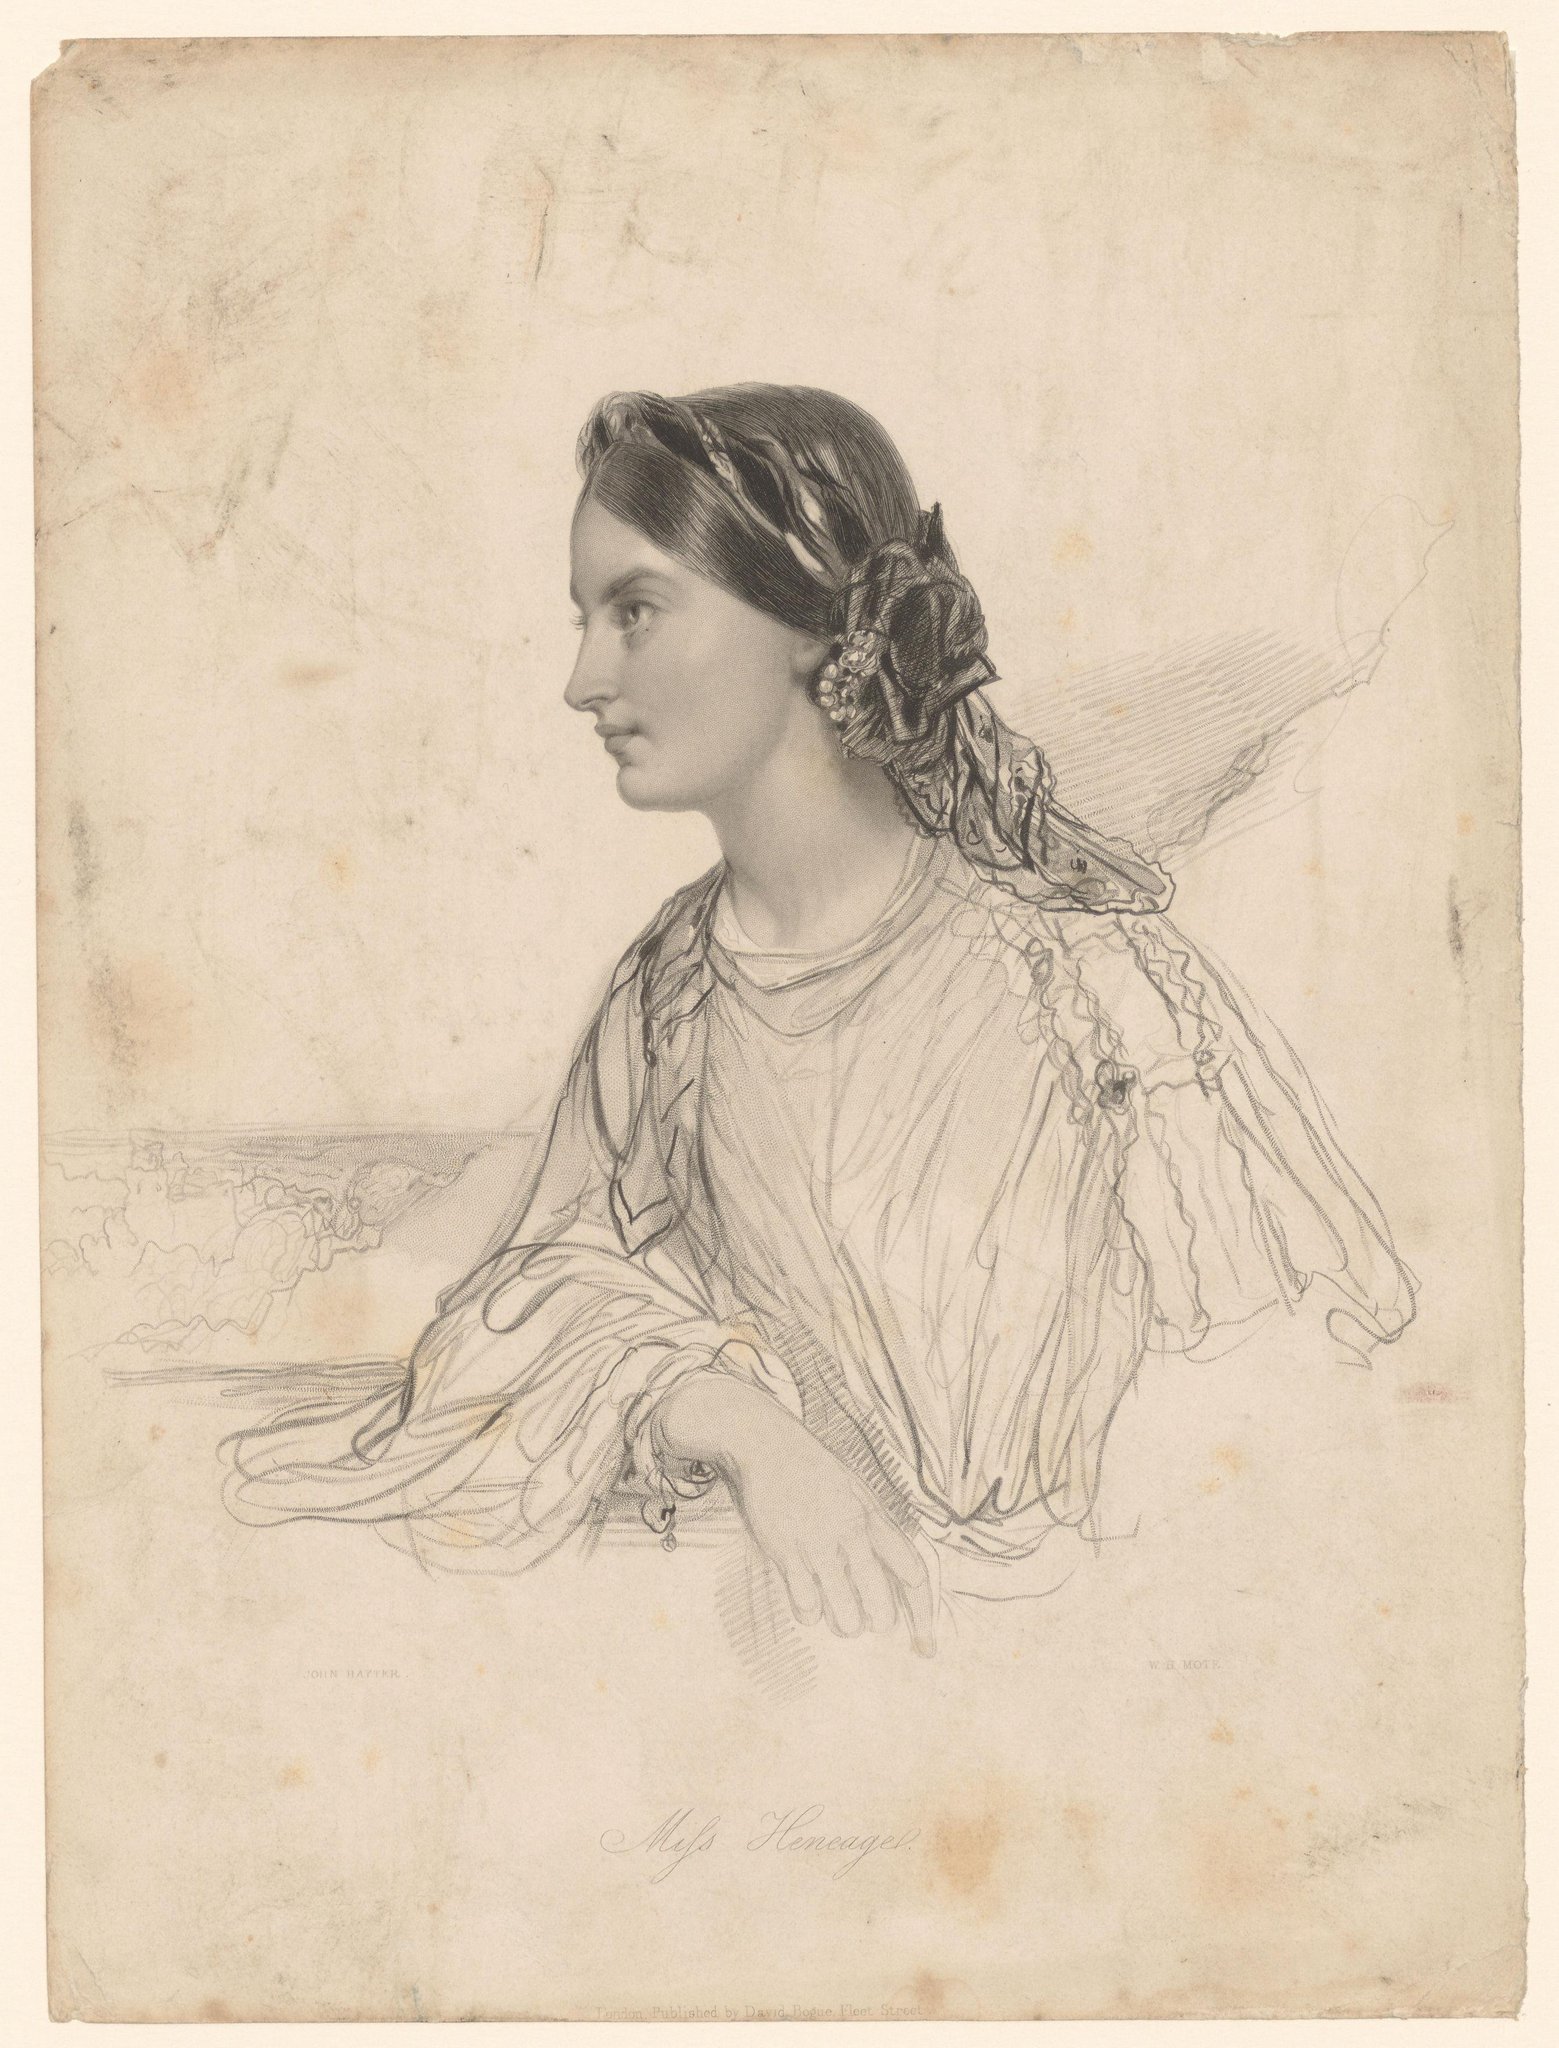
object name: print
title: Portret van mevrouw Heneage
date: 1852-1856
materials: paper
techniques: etching, roulette, engraving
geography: england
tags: historical persons - bb - woman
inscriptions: collector's mark: Lugt 2228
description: Prent uit: The Court Album: A Series of Portraits of the Female Aristocracy. Londen: David Bogue, [ca. 1852-1856].